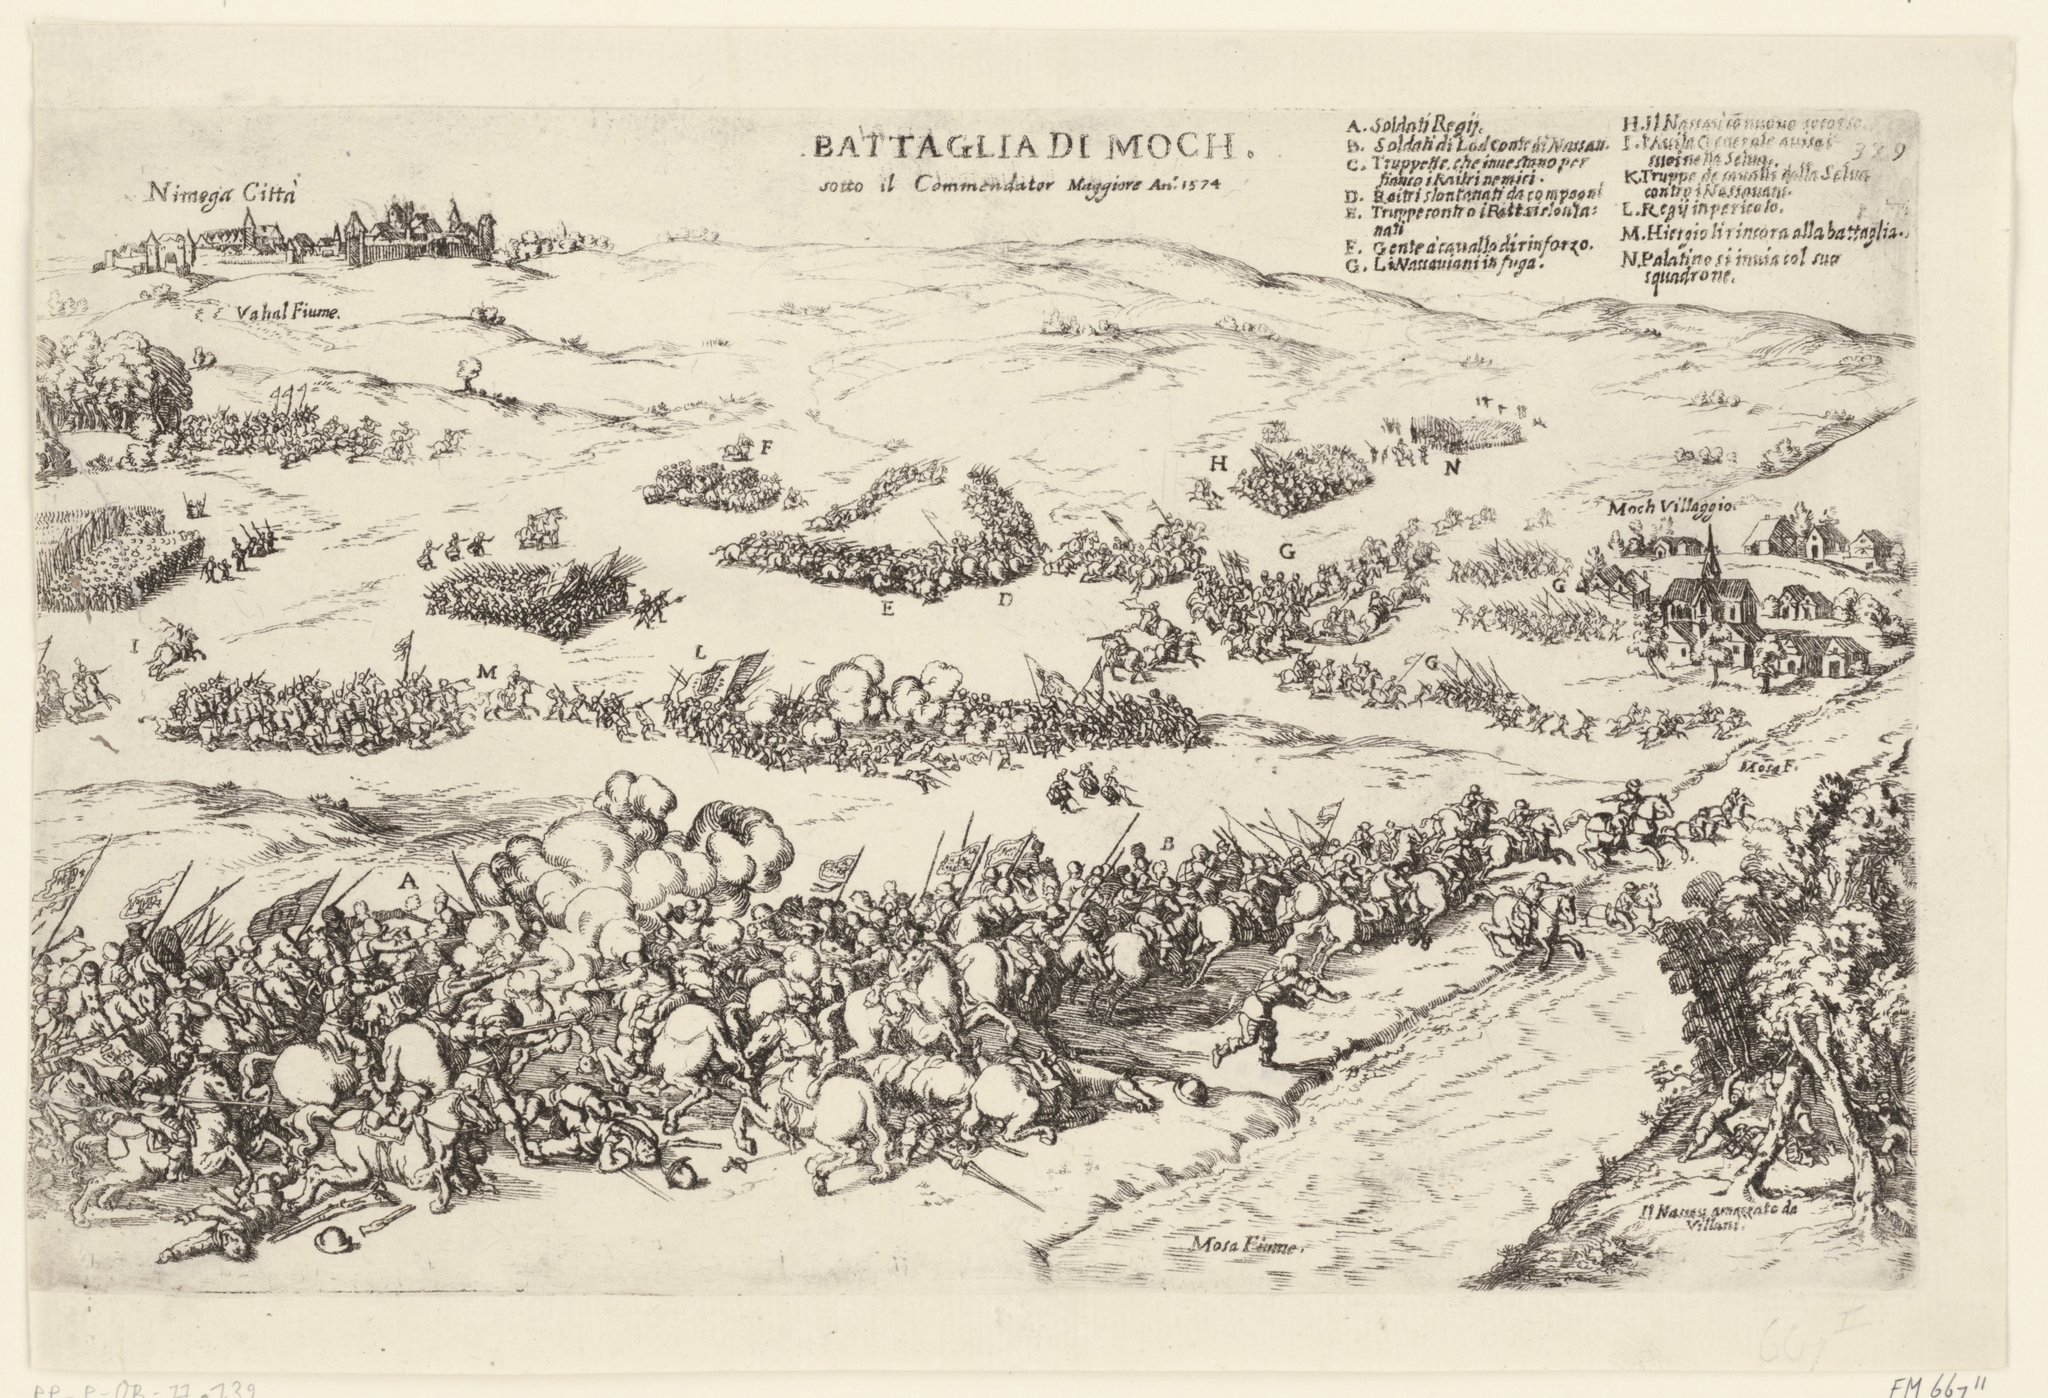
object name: history print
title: Battaglia di Moch, sotto il Commendator Maggiore An.o 1574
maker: Anonymous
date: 1632-1699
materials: paper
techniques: etching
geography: italy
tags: battle (+ land forces), historical events and situations, nijmegen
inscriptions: title: ‘BATTAGLIA DI MOCH’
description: Slag op de Mookerheide op 14 april 1574. Op de voorgrond en in het midden zware gevechten tussen ruiters. Rechts het dorpje Mook, links in de verte Nijmegen. Rechtsboven in de voorstelling de legenda A-N in het Italiaans.